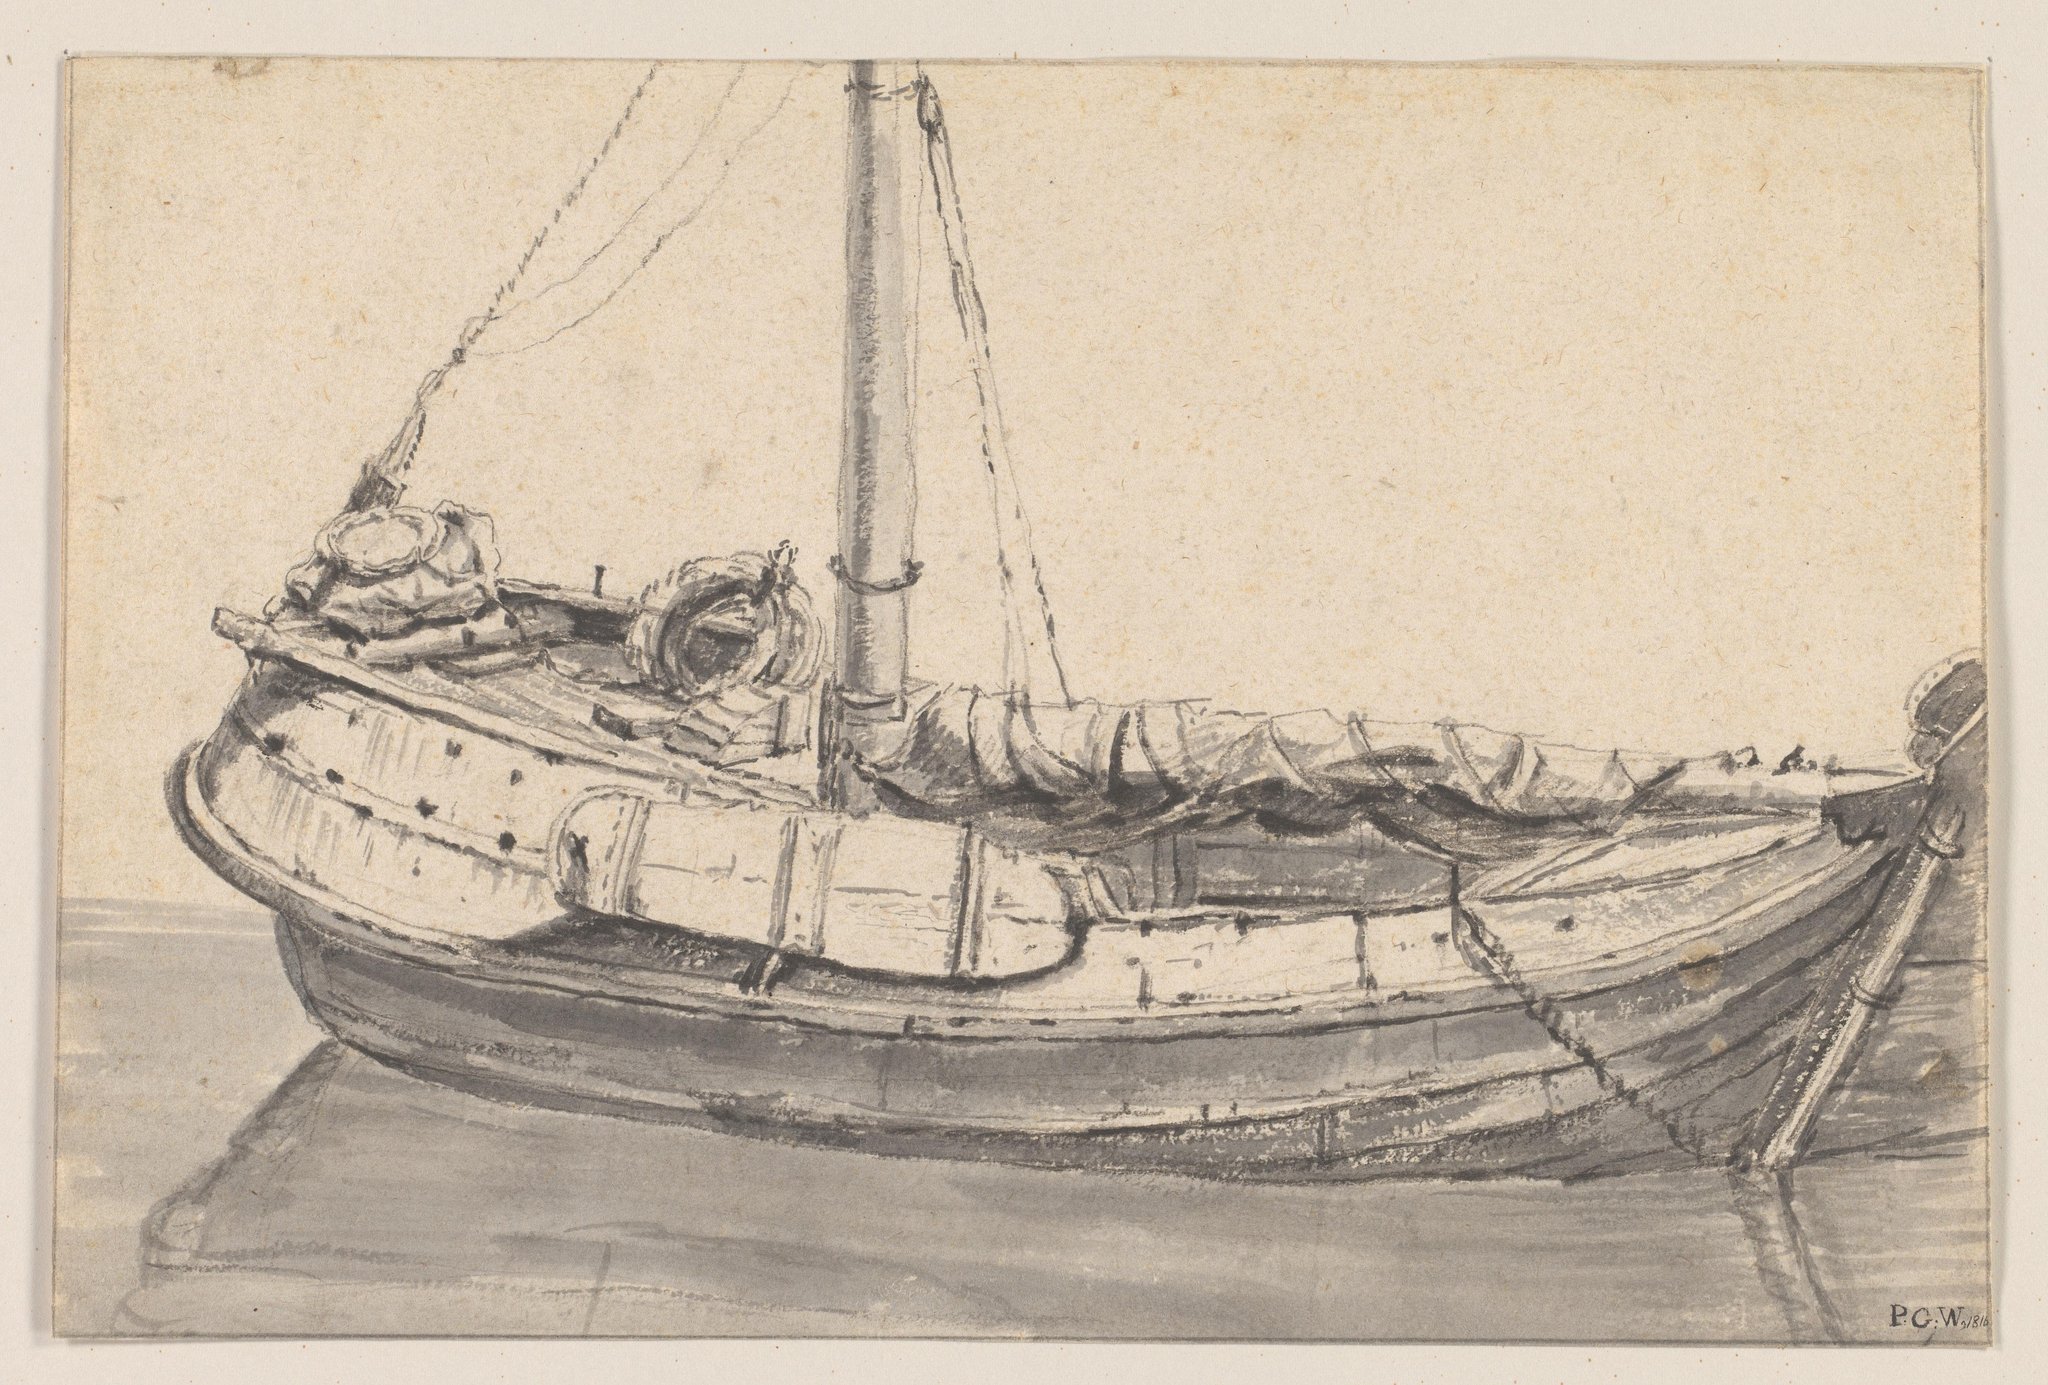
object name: drawing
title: Schip, de boeg links gewend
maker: george pieter westenberg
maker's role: draughtsman, painter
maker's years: 1791-1873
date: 1816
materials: chalk, paper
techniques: brush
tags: ships (in general)